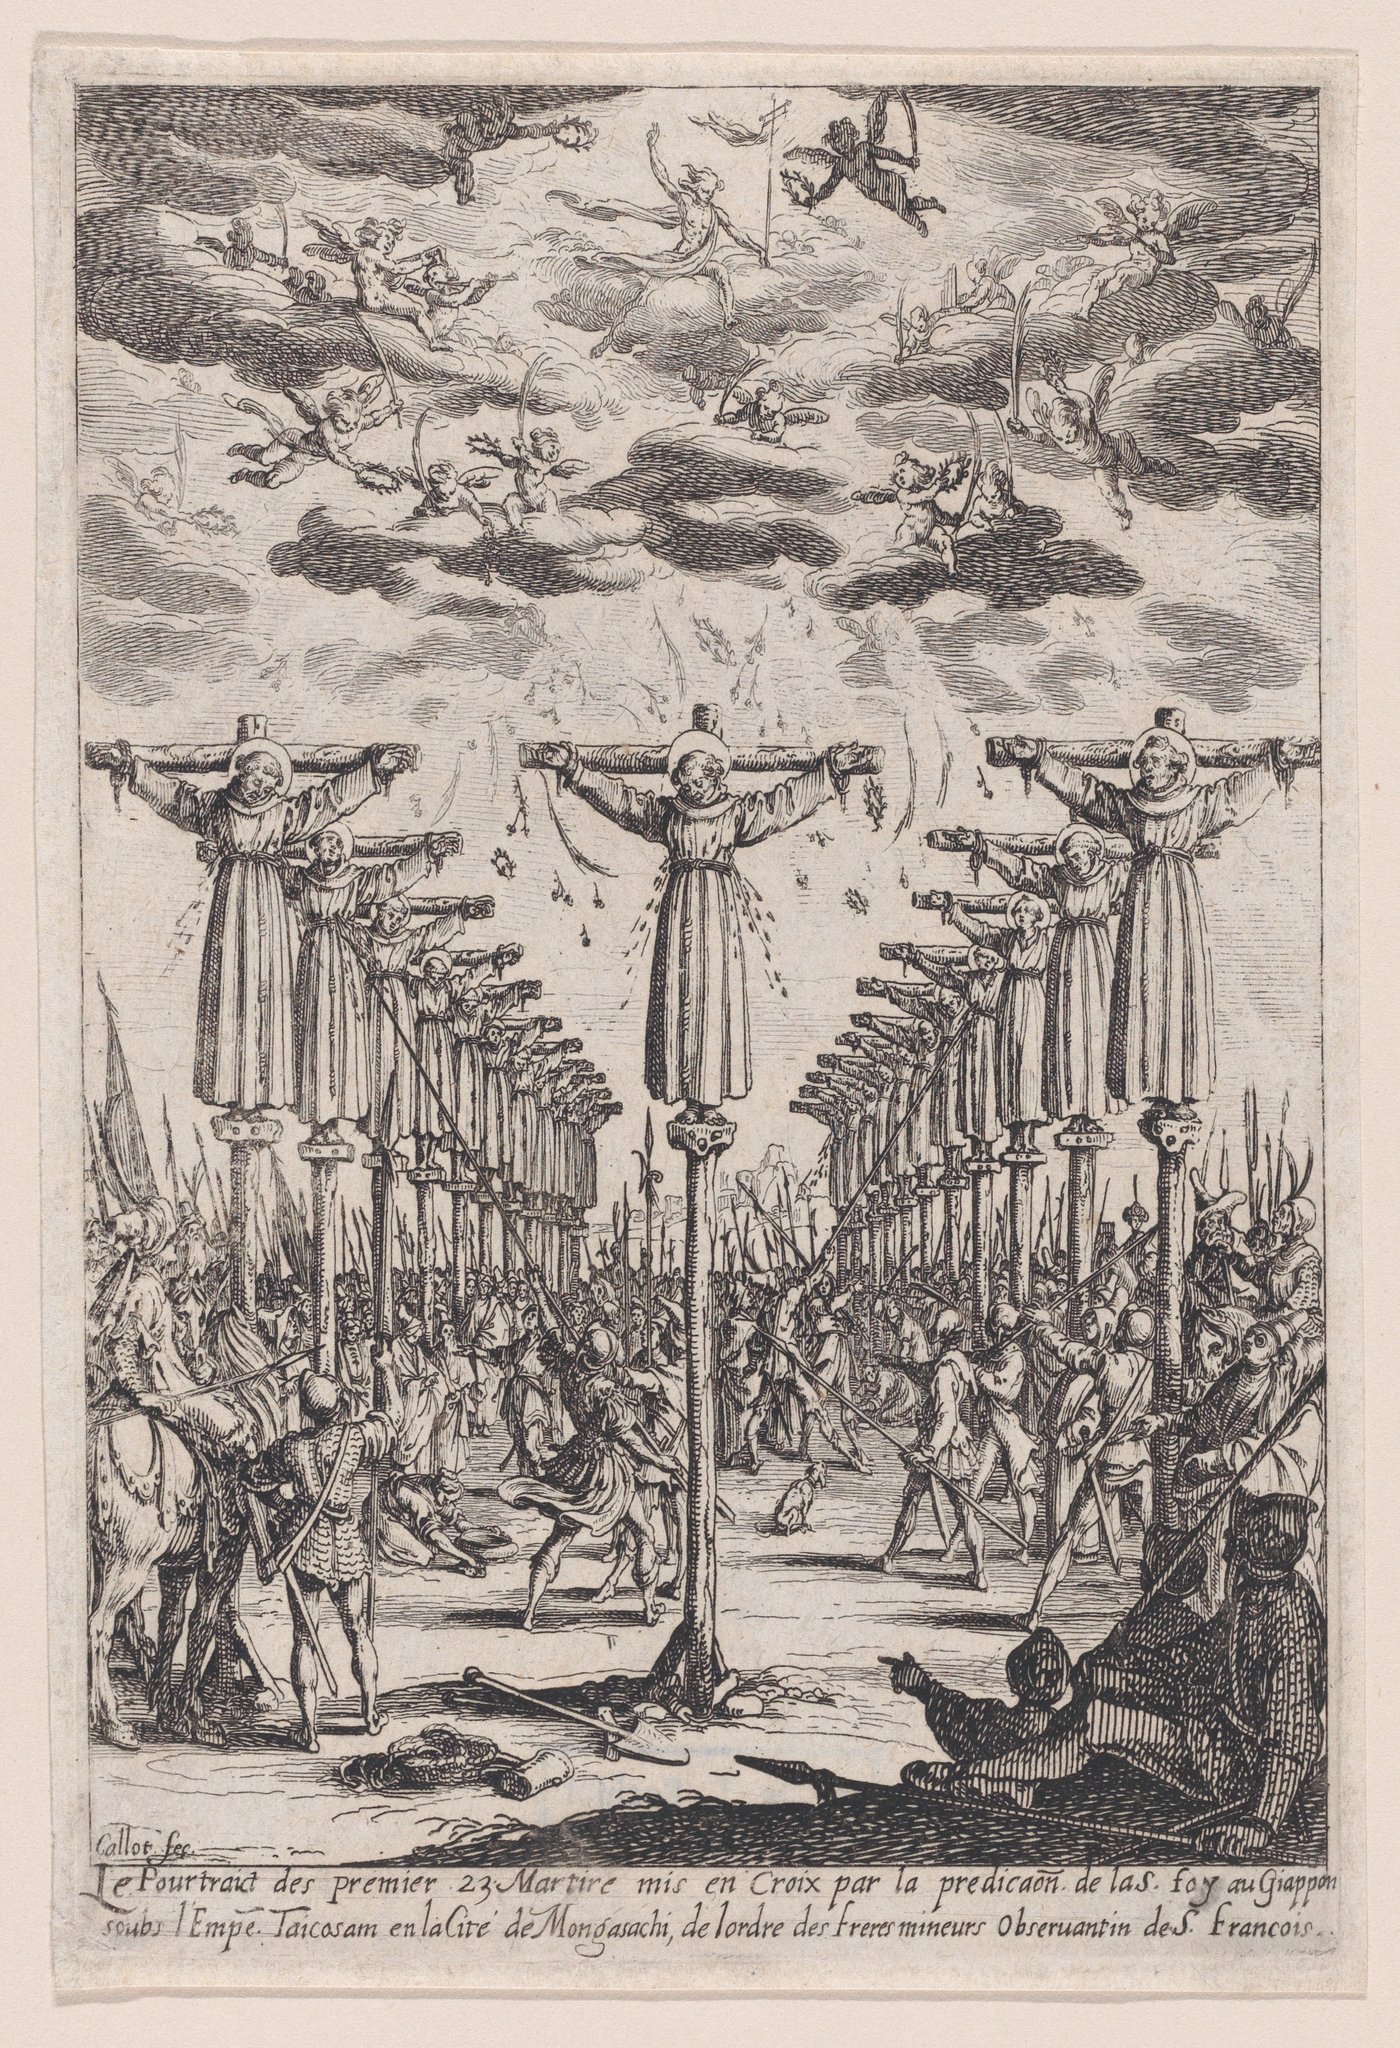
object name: print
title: Les Martyrs du Japon (The Martyrs of Japan)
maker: jacques callot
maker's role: artist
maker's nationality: french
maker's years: 1592-1635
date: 1627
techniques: etching